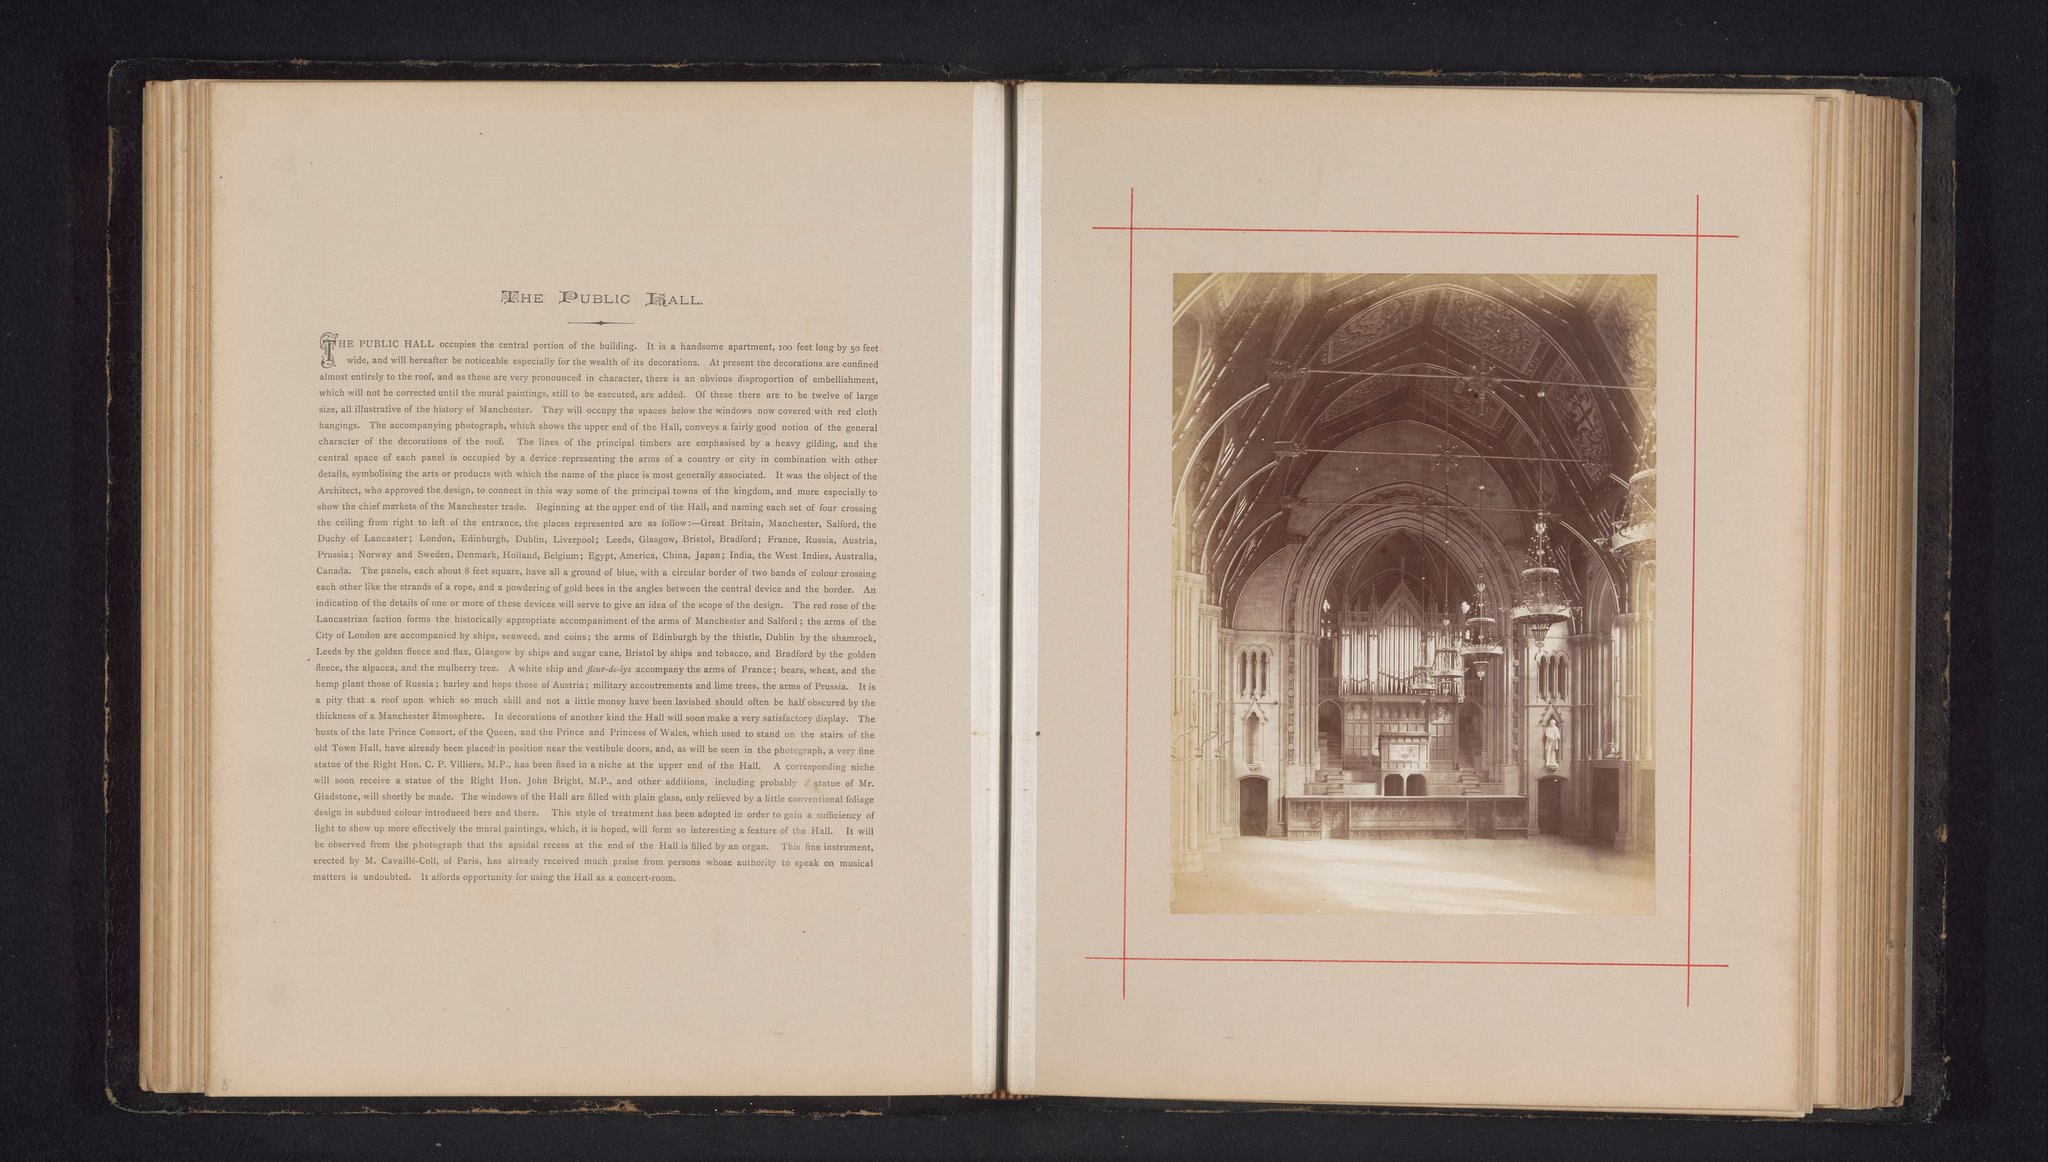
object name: page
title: Vestibule in het Stadhuis van Manchester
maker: j. mcleod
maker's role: fotograaf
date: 1877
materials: photographic support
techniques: albumen print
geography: manchester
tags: townhall, vestibule, hall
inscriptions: title: ‘The Public Hall’